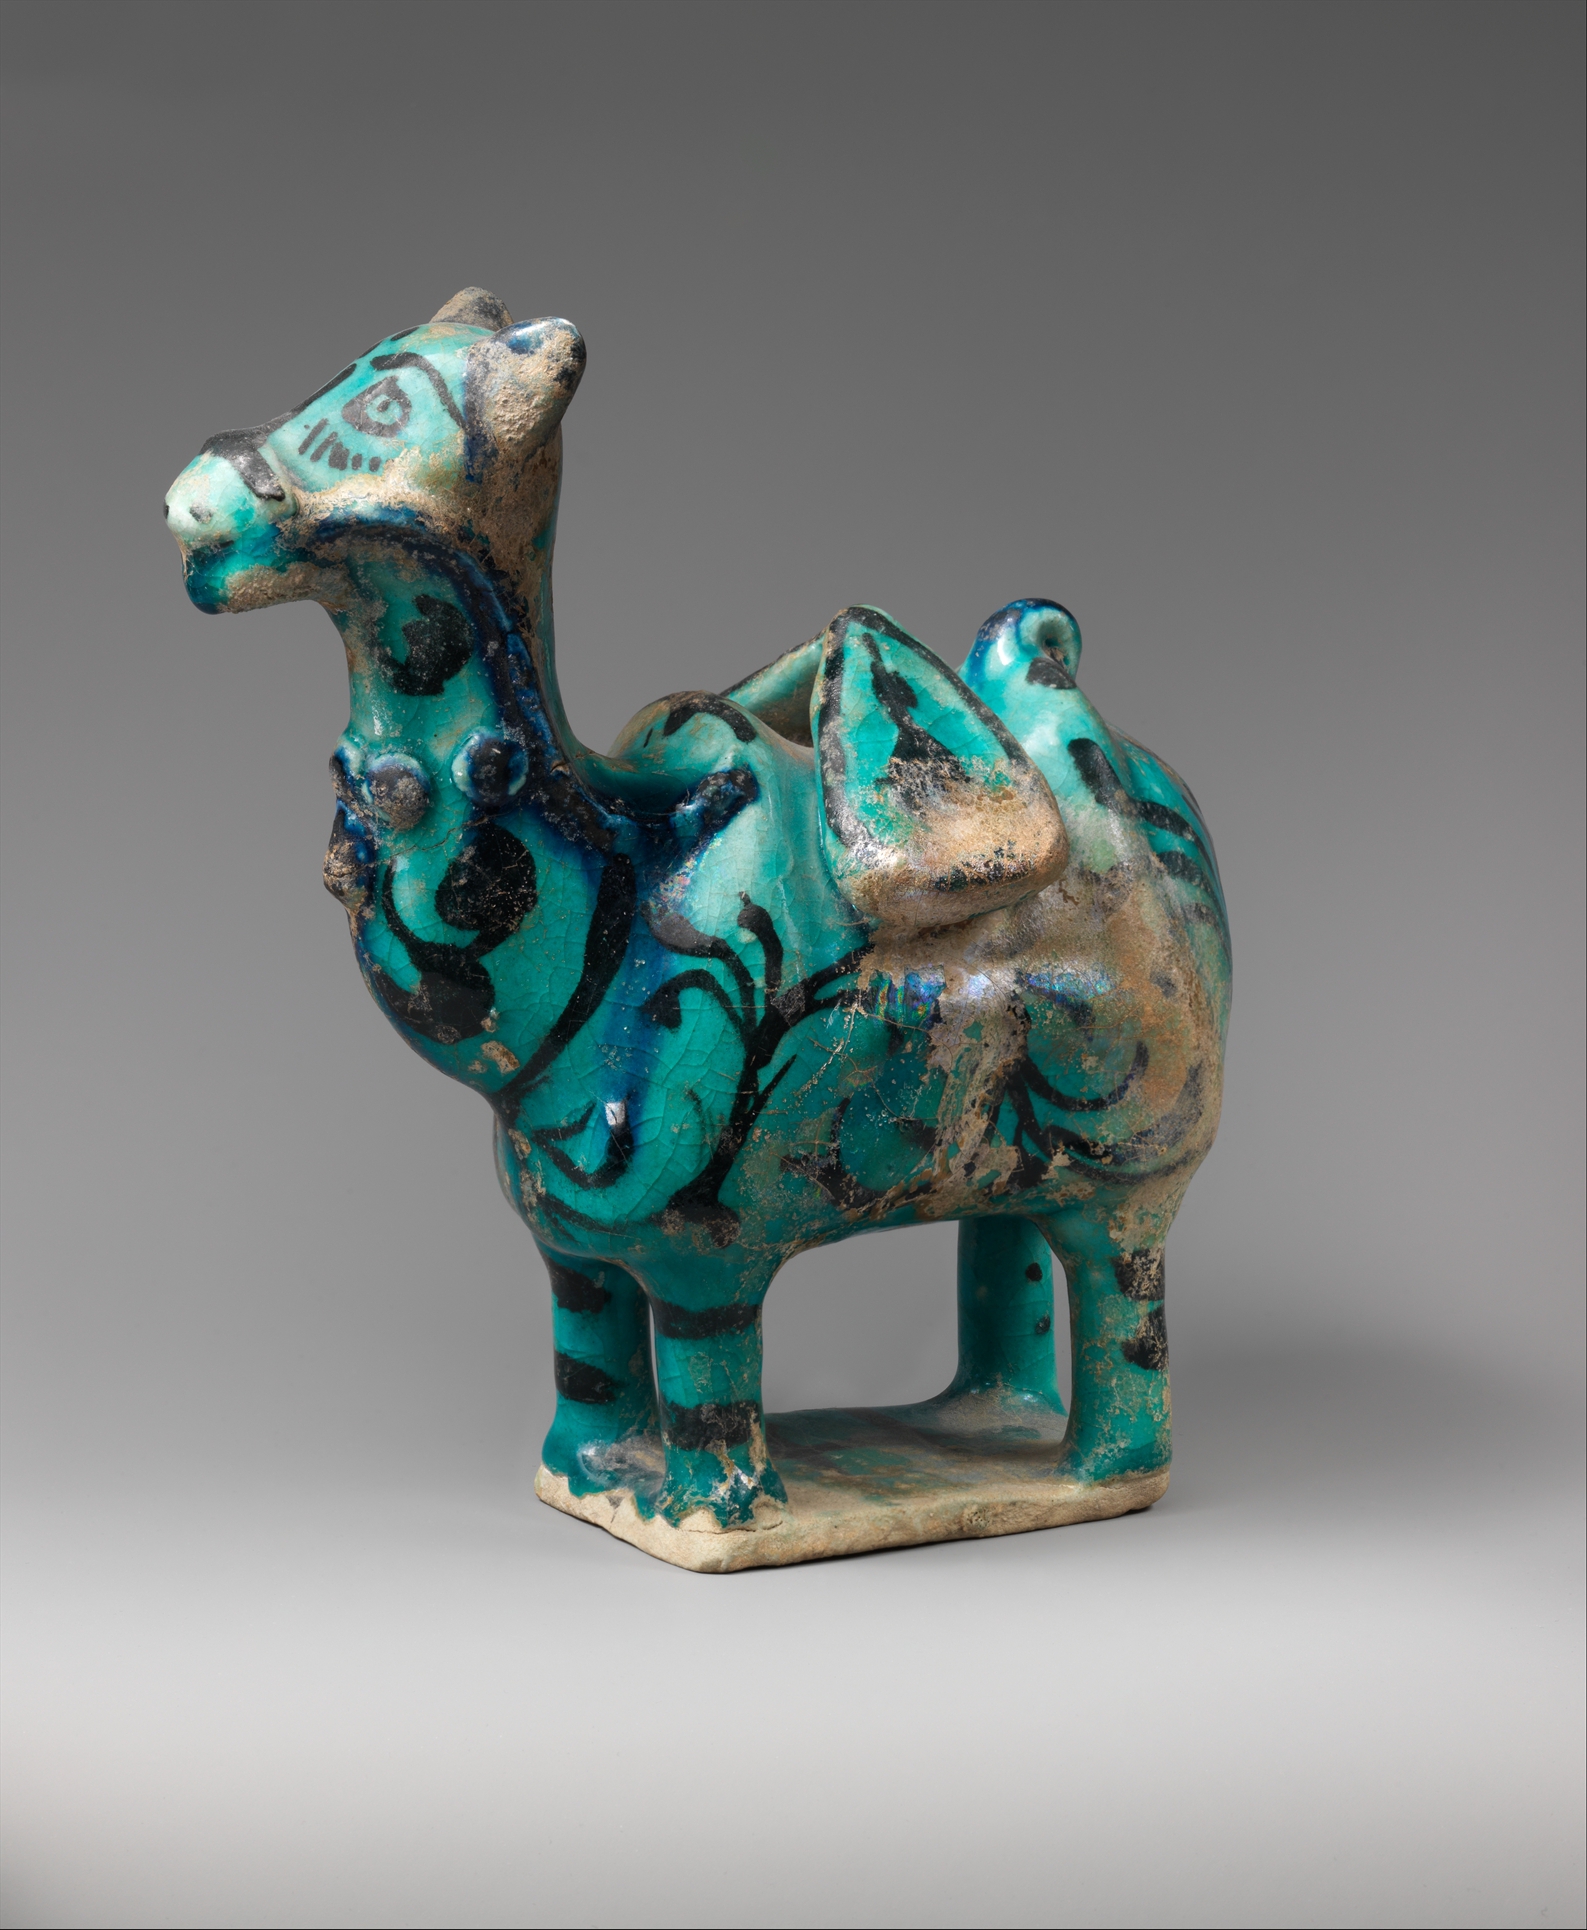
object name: figure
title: Figure of a Dromedary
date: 1101-1300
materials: stonepaste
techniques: painting, underglaze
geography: iran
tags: camels